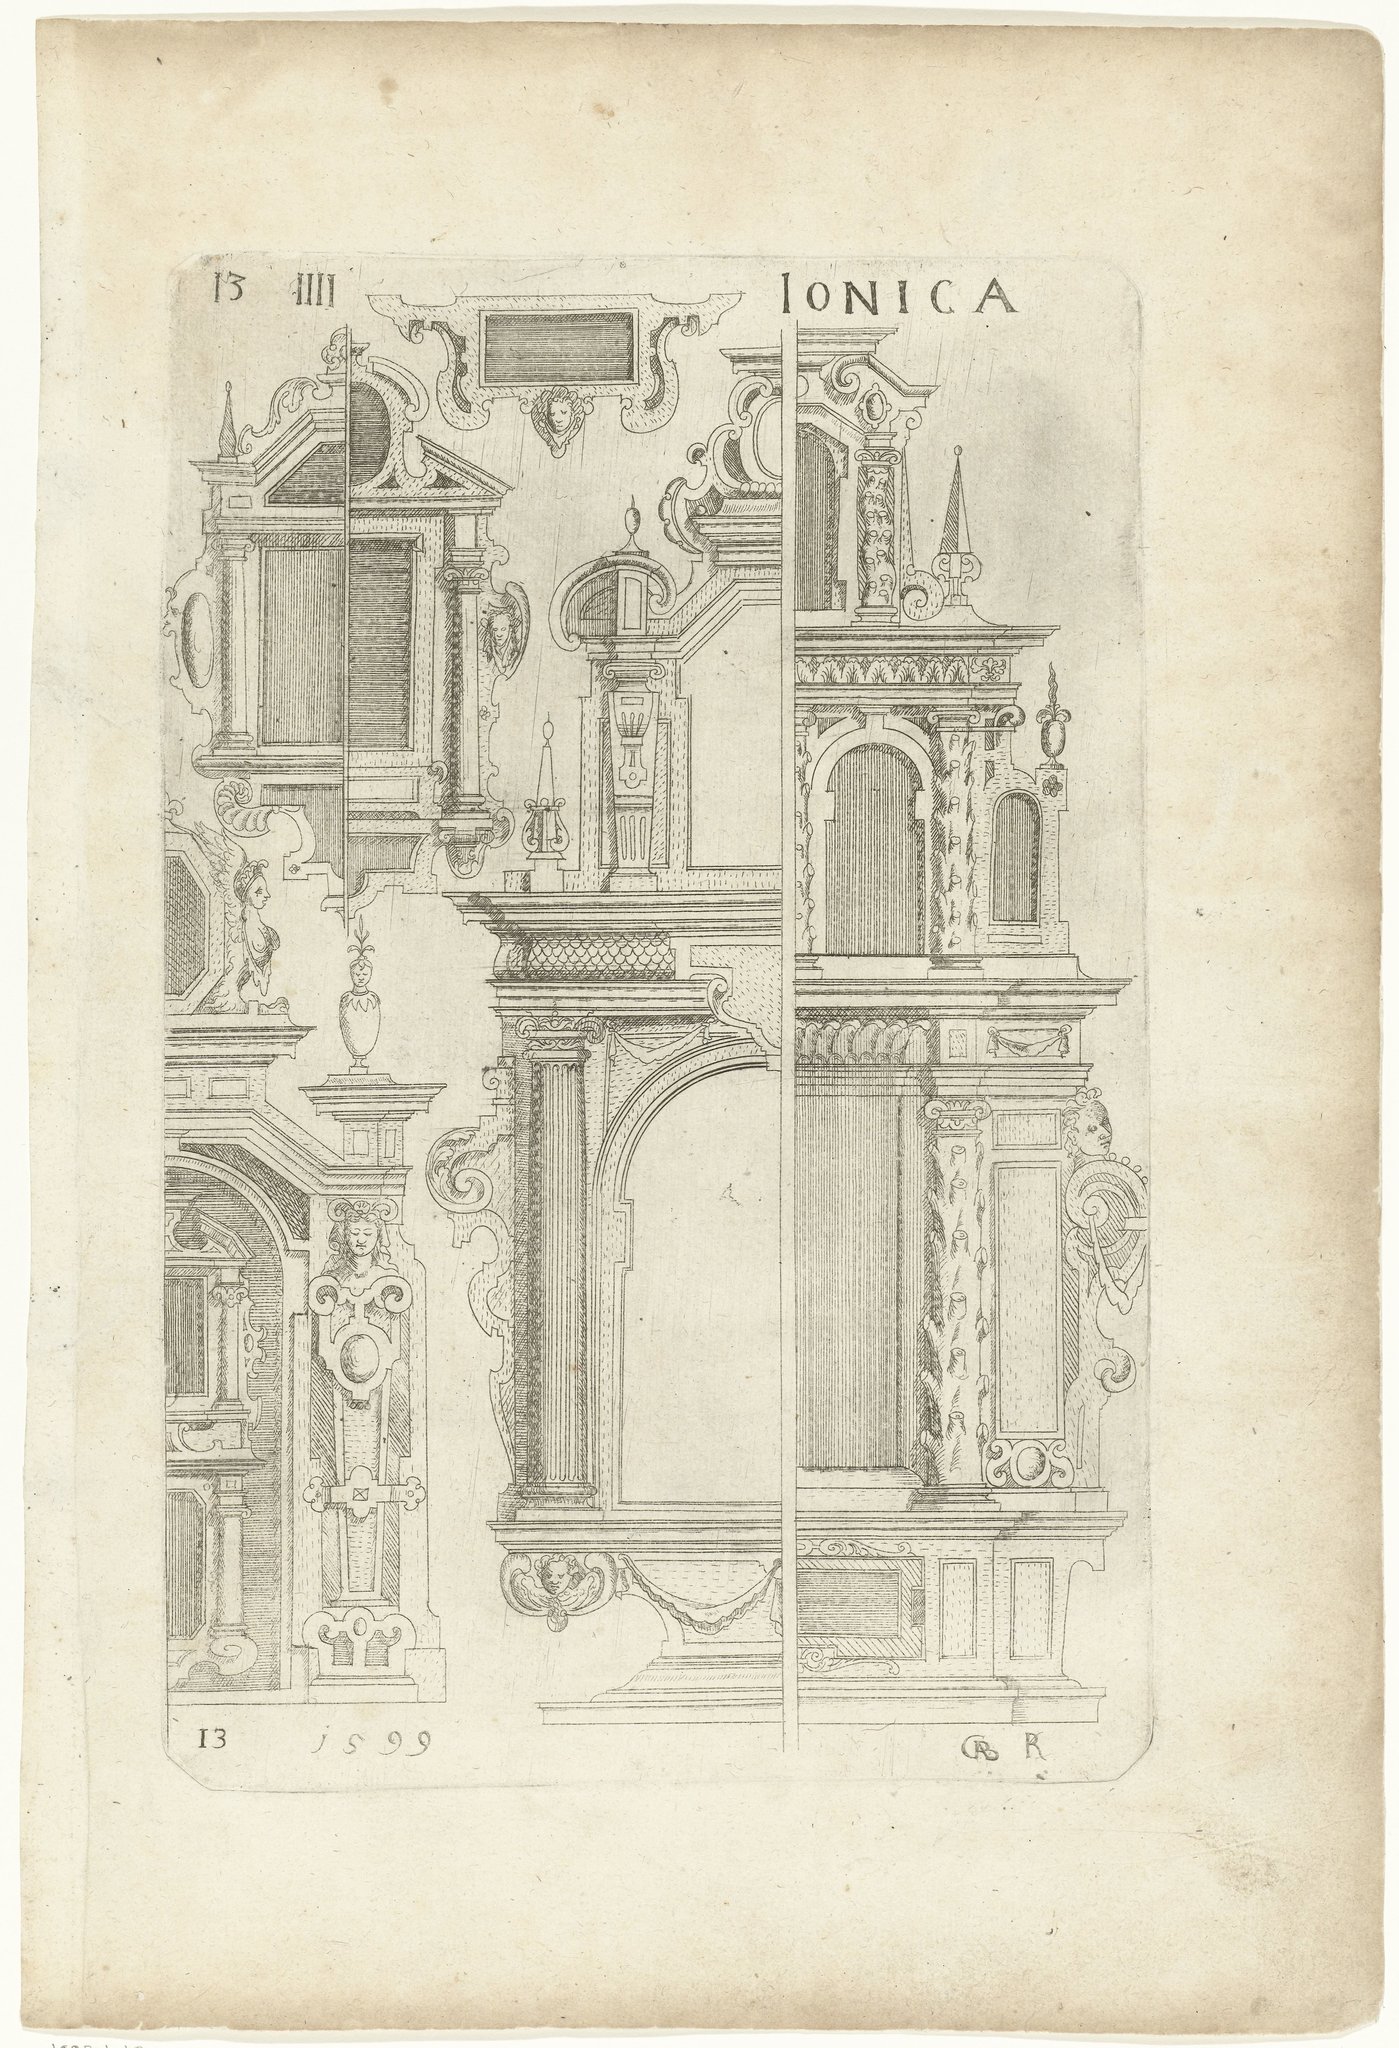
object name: ornament print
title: Architectura von den funf Seuvlen (...)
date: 1610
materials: paper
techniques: etching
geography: cologne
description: Bovenaan zijn zes balusters of termen van voren afgebeeld met daarnaast vijf pinakels, onderaan zijn vier termen in de vorm van rolwerkconsoles van opzij te zien. Blad 13 uit serie van titelblad en 28 bladen.